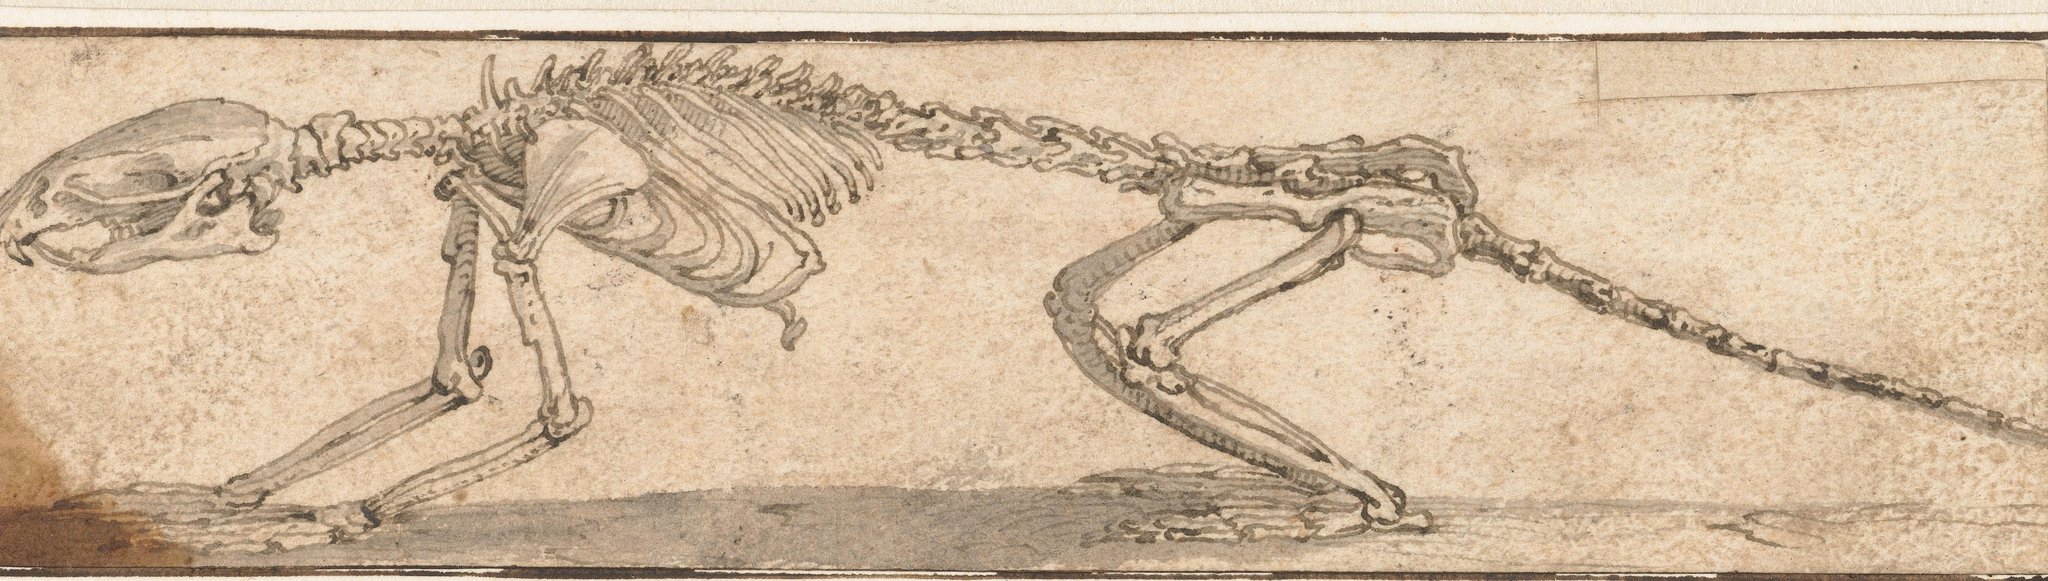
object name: drawing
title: Skelet van een rat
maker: jacopo ligozzi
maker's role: designer, draughtsman, painter, print maker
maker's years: 1547-1627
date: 1557-1626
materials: ink, paper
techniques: brush, pen